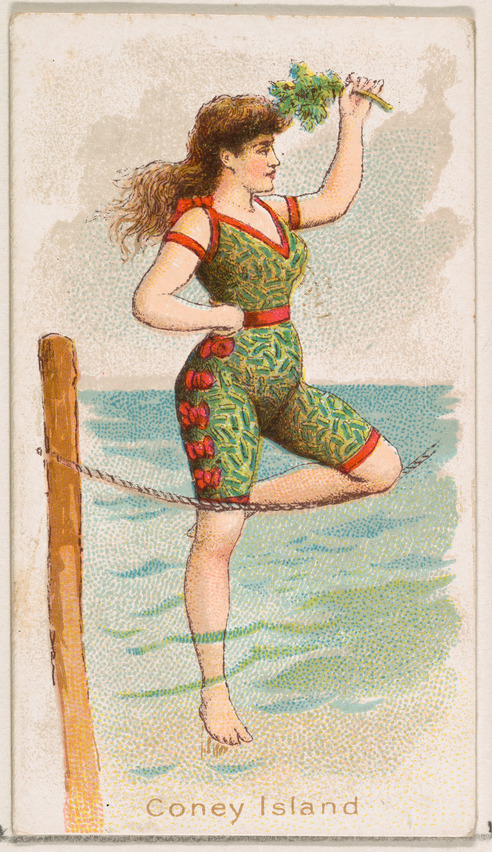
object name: print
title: Coney Island, from the Fancy Bathers series (N187) issued by Wm. S. Kimball & Co.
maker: william s. kimball & company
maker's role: publisher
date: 1889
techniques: color lithograph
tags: profiles,women